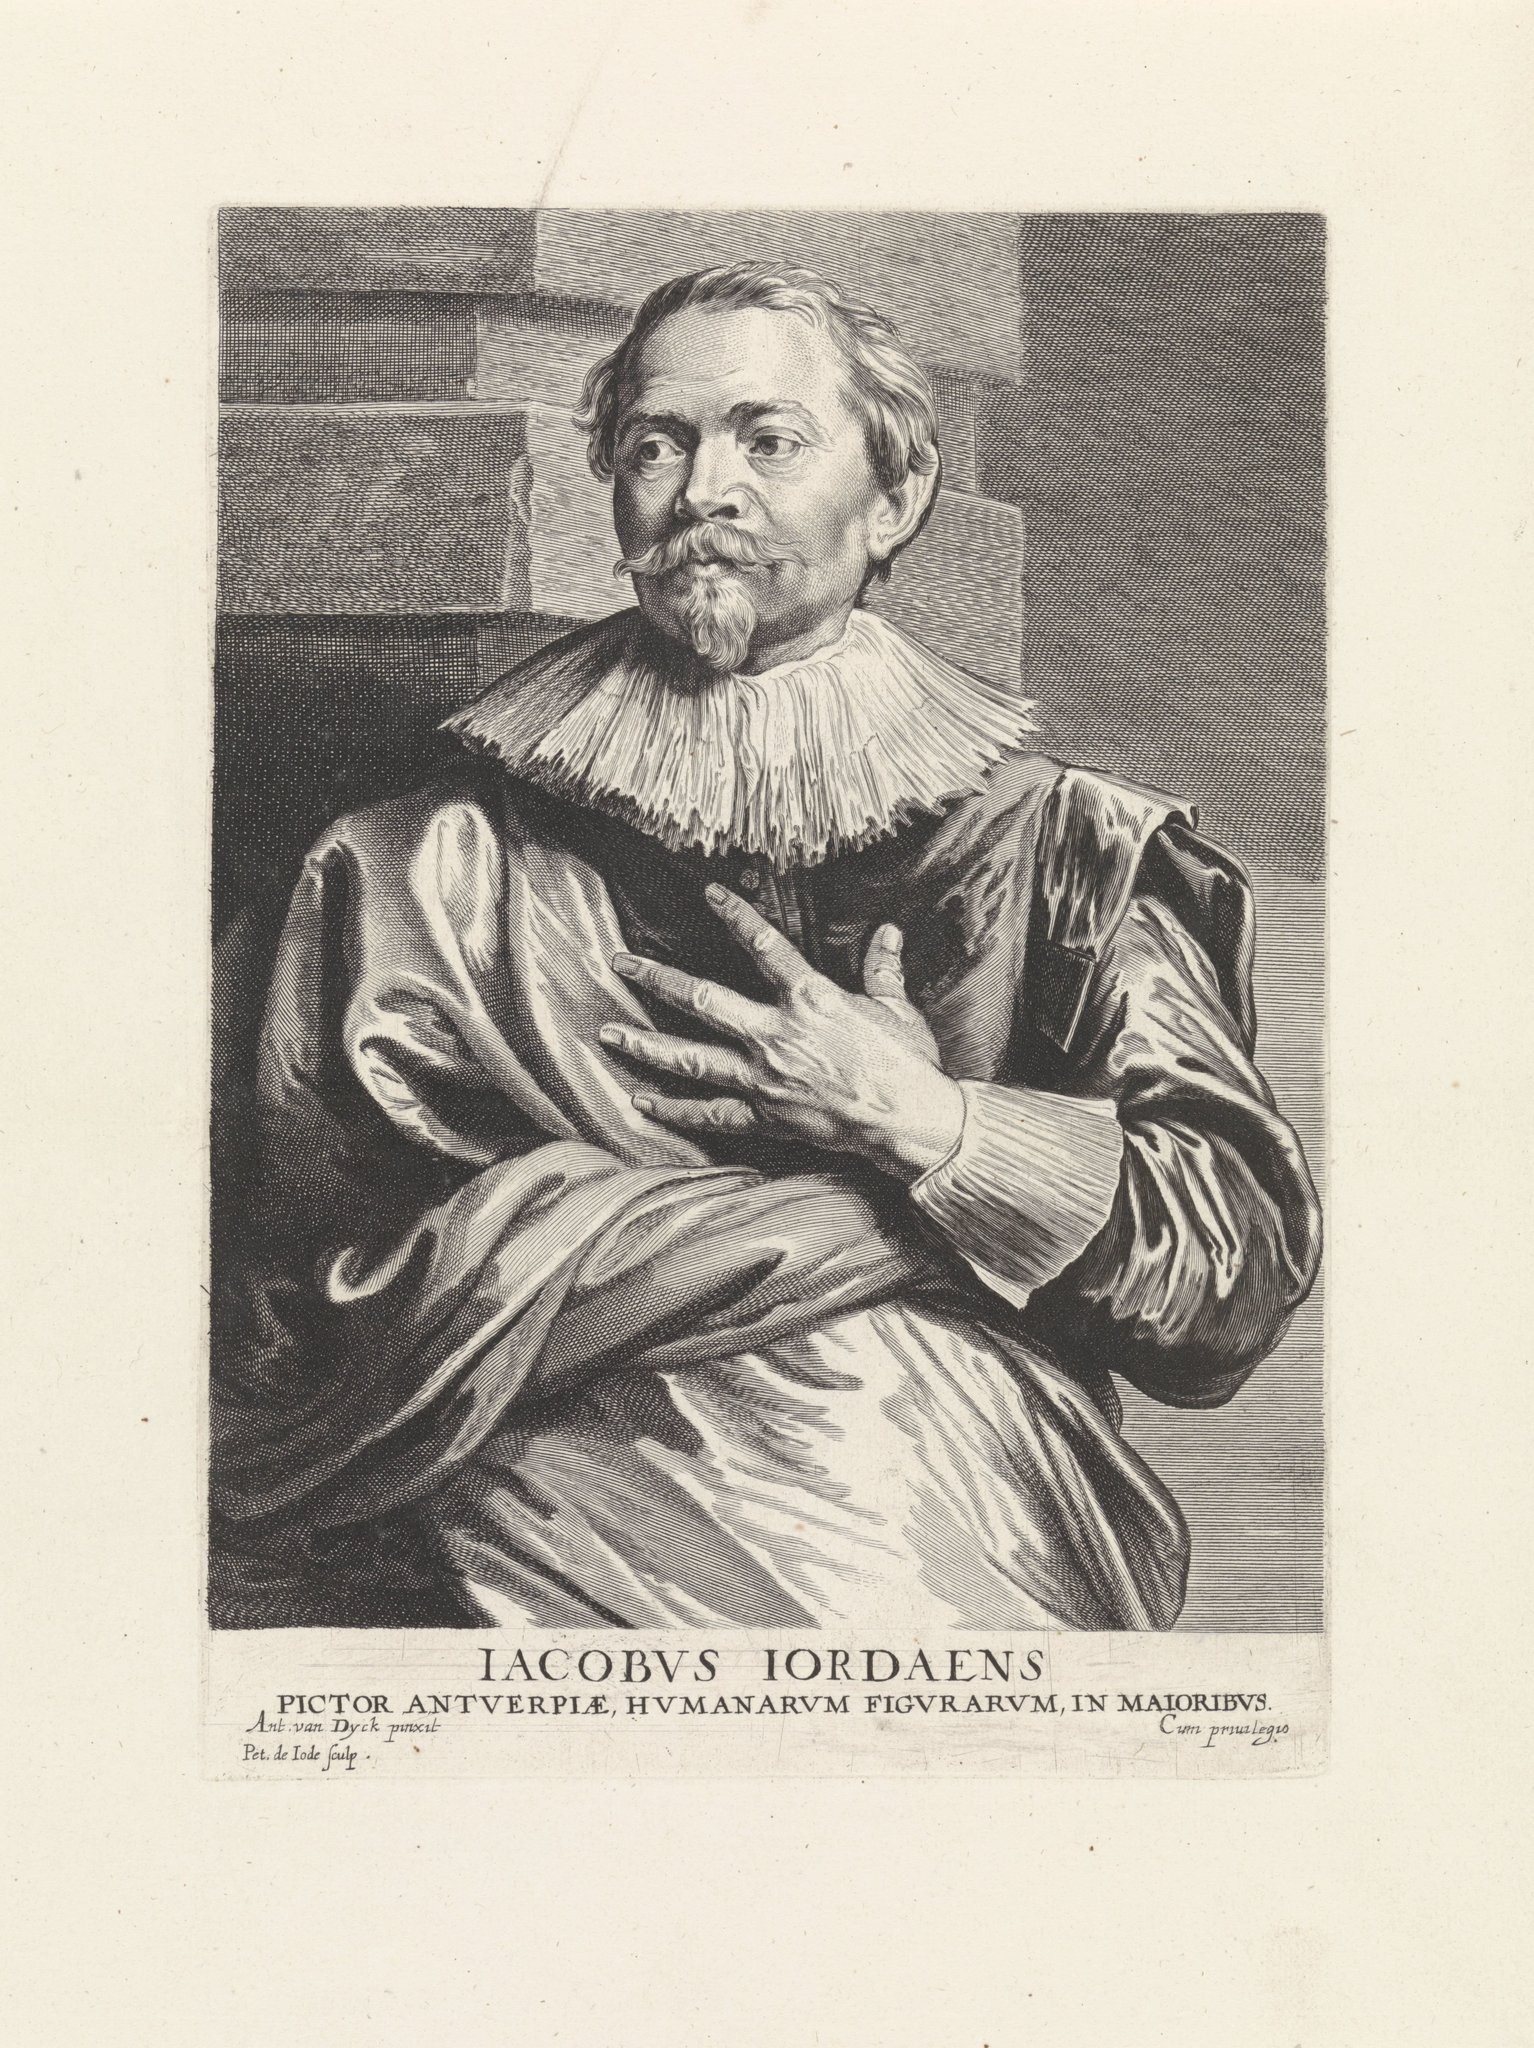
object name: print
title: Portret van Jacques Jordaens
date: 1628-1670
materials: paper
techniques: engraving, etching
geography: antwerp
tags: painter, print maker, draughtsman, designer, jacques jordaens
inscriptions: collector's mark: Lugt 2228, collector's mark: Lugt 2166, collector's mark: Lugt 2760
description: Portret van de kunstenaat Jacques Jordaens, ten halven lijve. Hij houdt zijn linkerhand tegen zijn borst. In de marge de naam van de geportretteerde en een onderschrift in het Latijn.